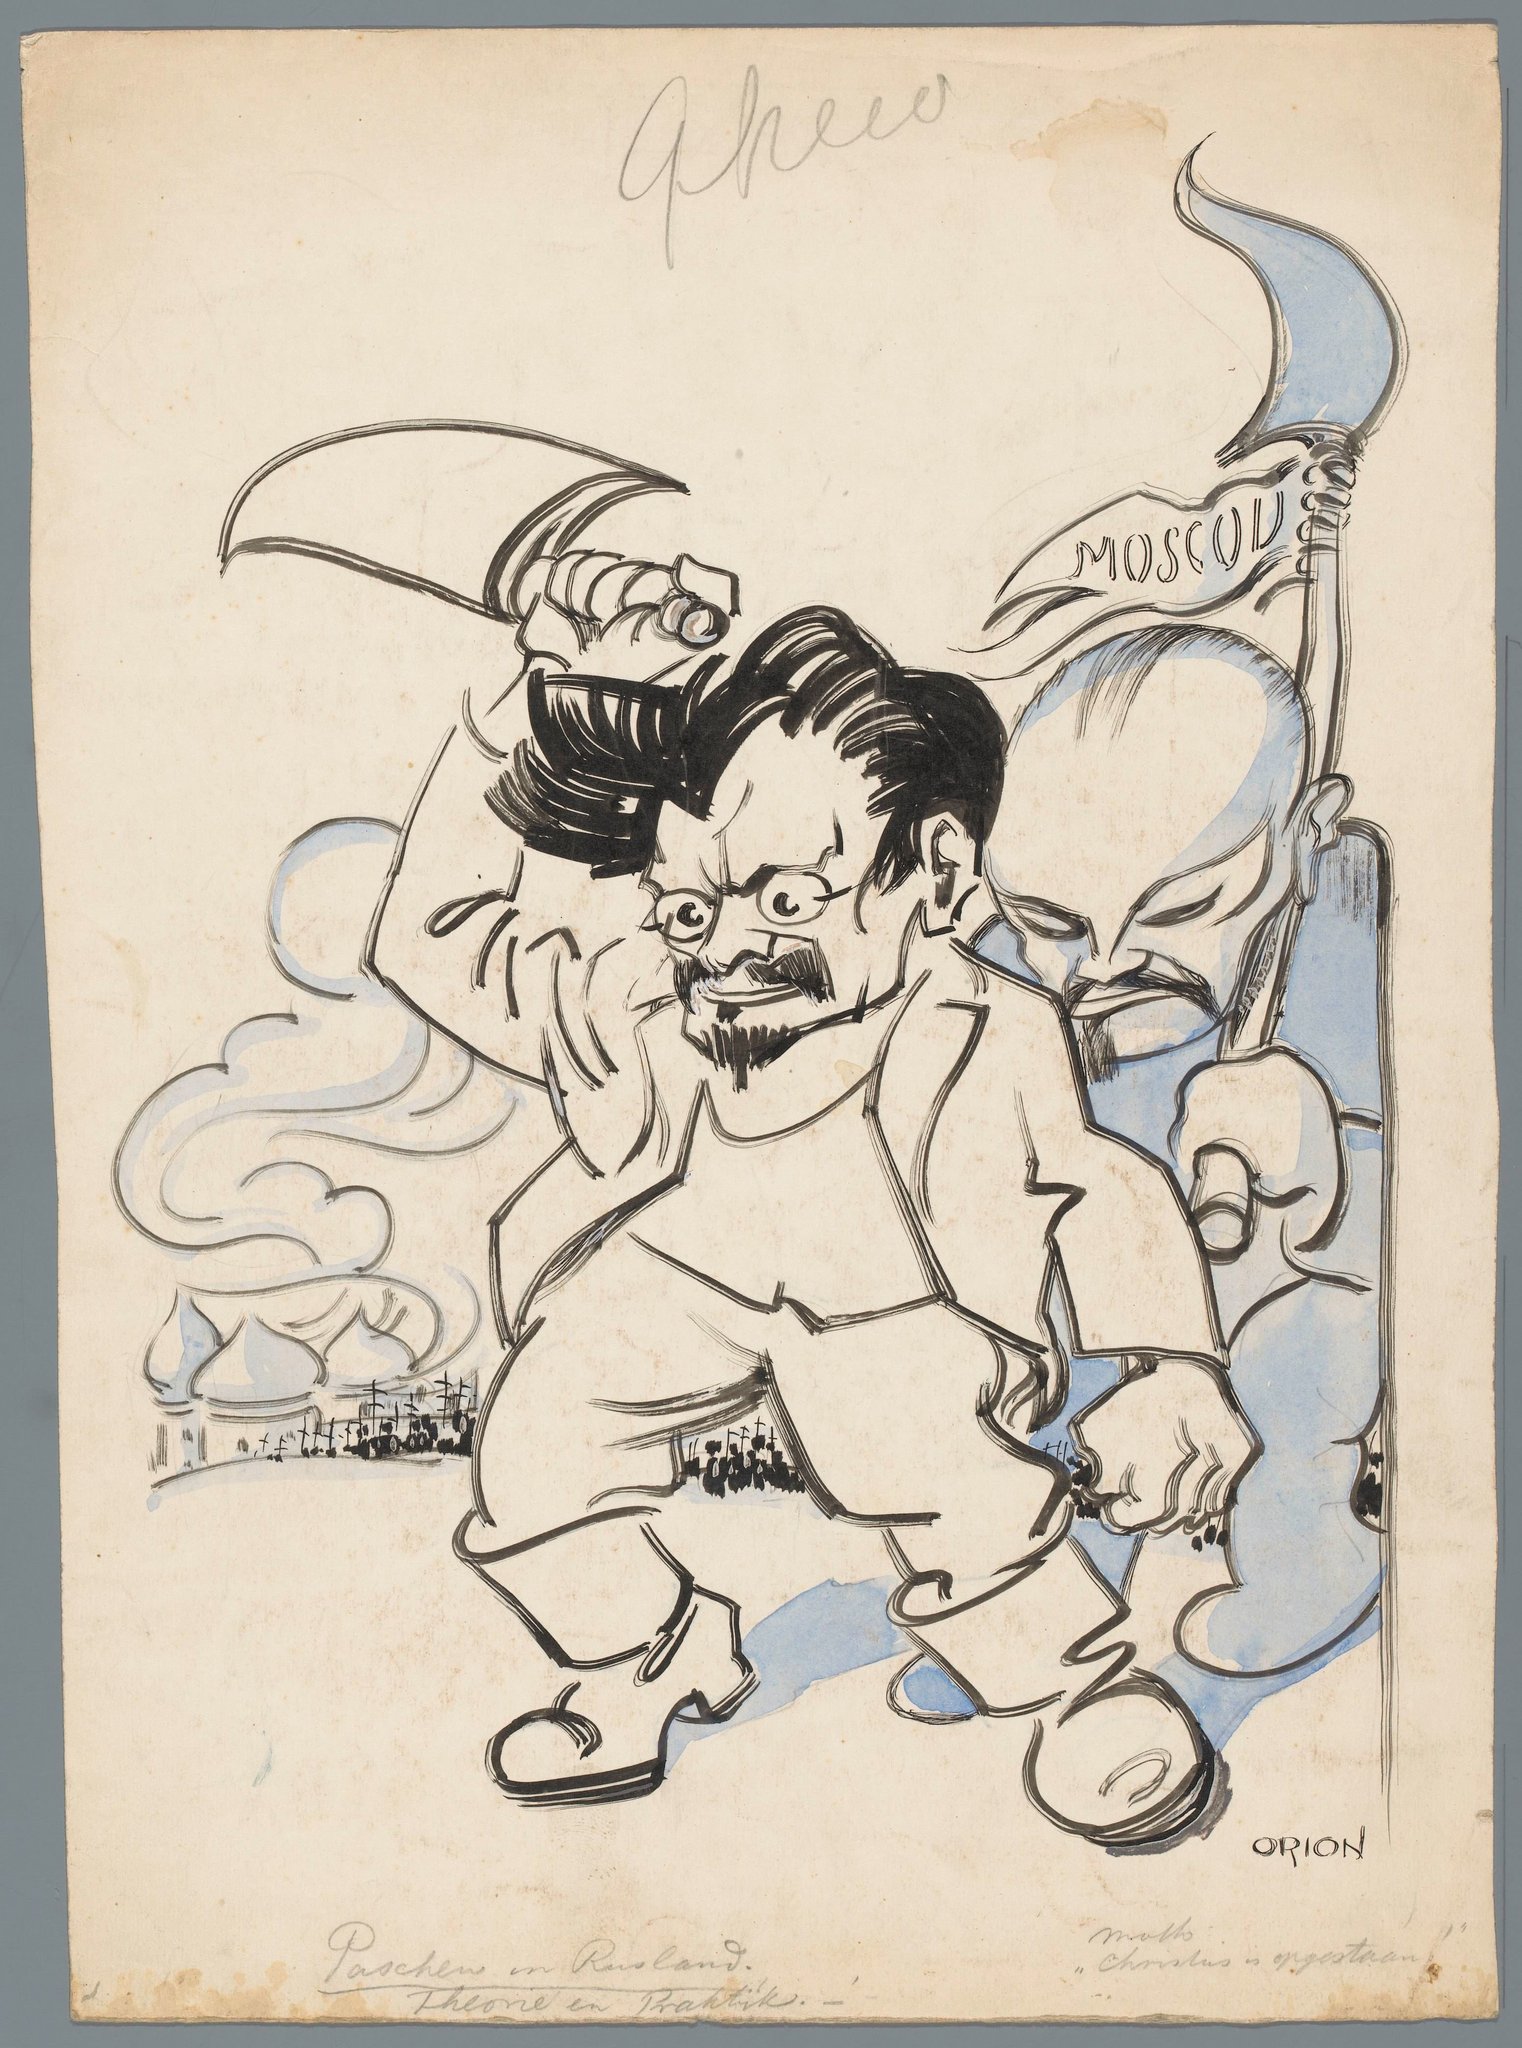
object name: drawing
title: Troksi en Lenin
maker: patricq kroon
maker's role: draughtsman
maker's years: 1862-1941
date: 1918-1920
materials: ink, paper, pencil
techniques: brush, pen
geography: netherlands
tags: politician, political caricatures and satires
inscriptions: inscription: ‘Paschen in Rusland. Theorie en Praktijk’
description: Trotski met slagersmes en Lenin met speer in Moskou. Ontwerp voor een politieke spotprent.